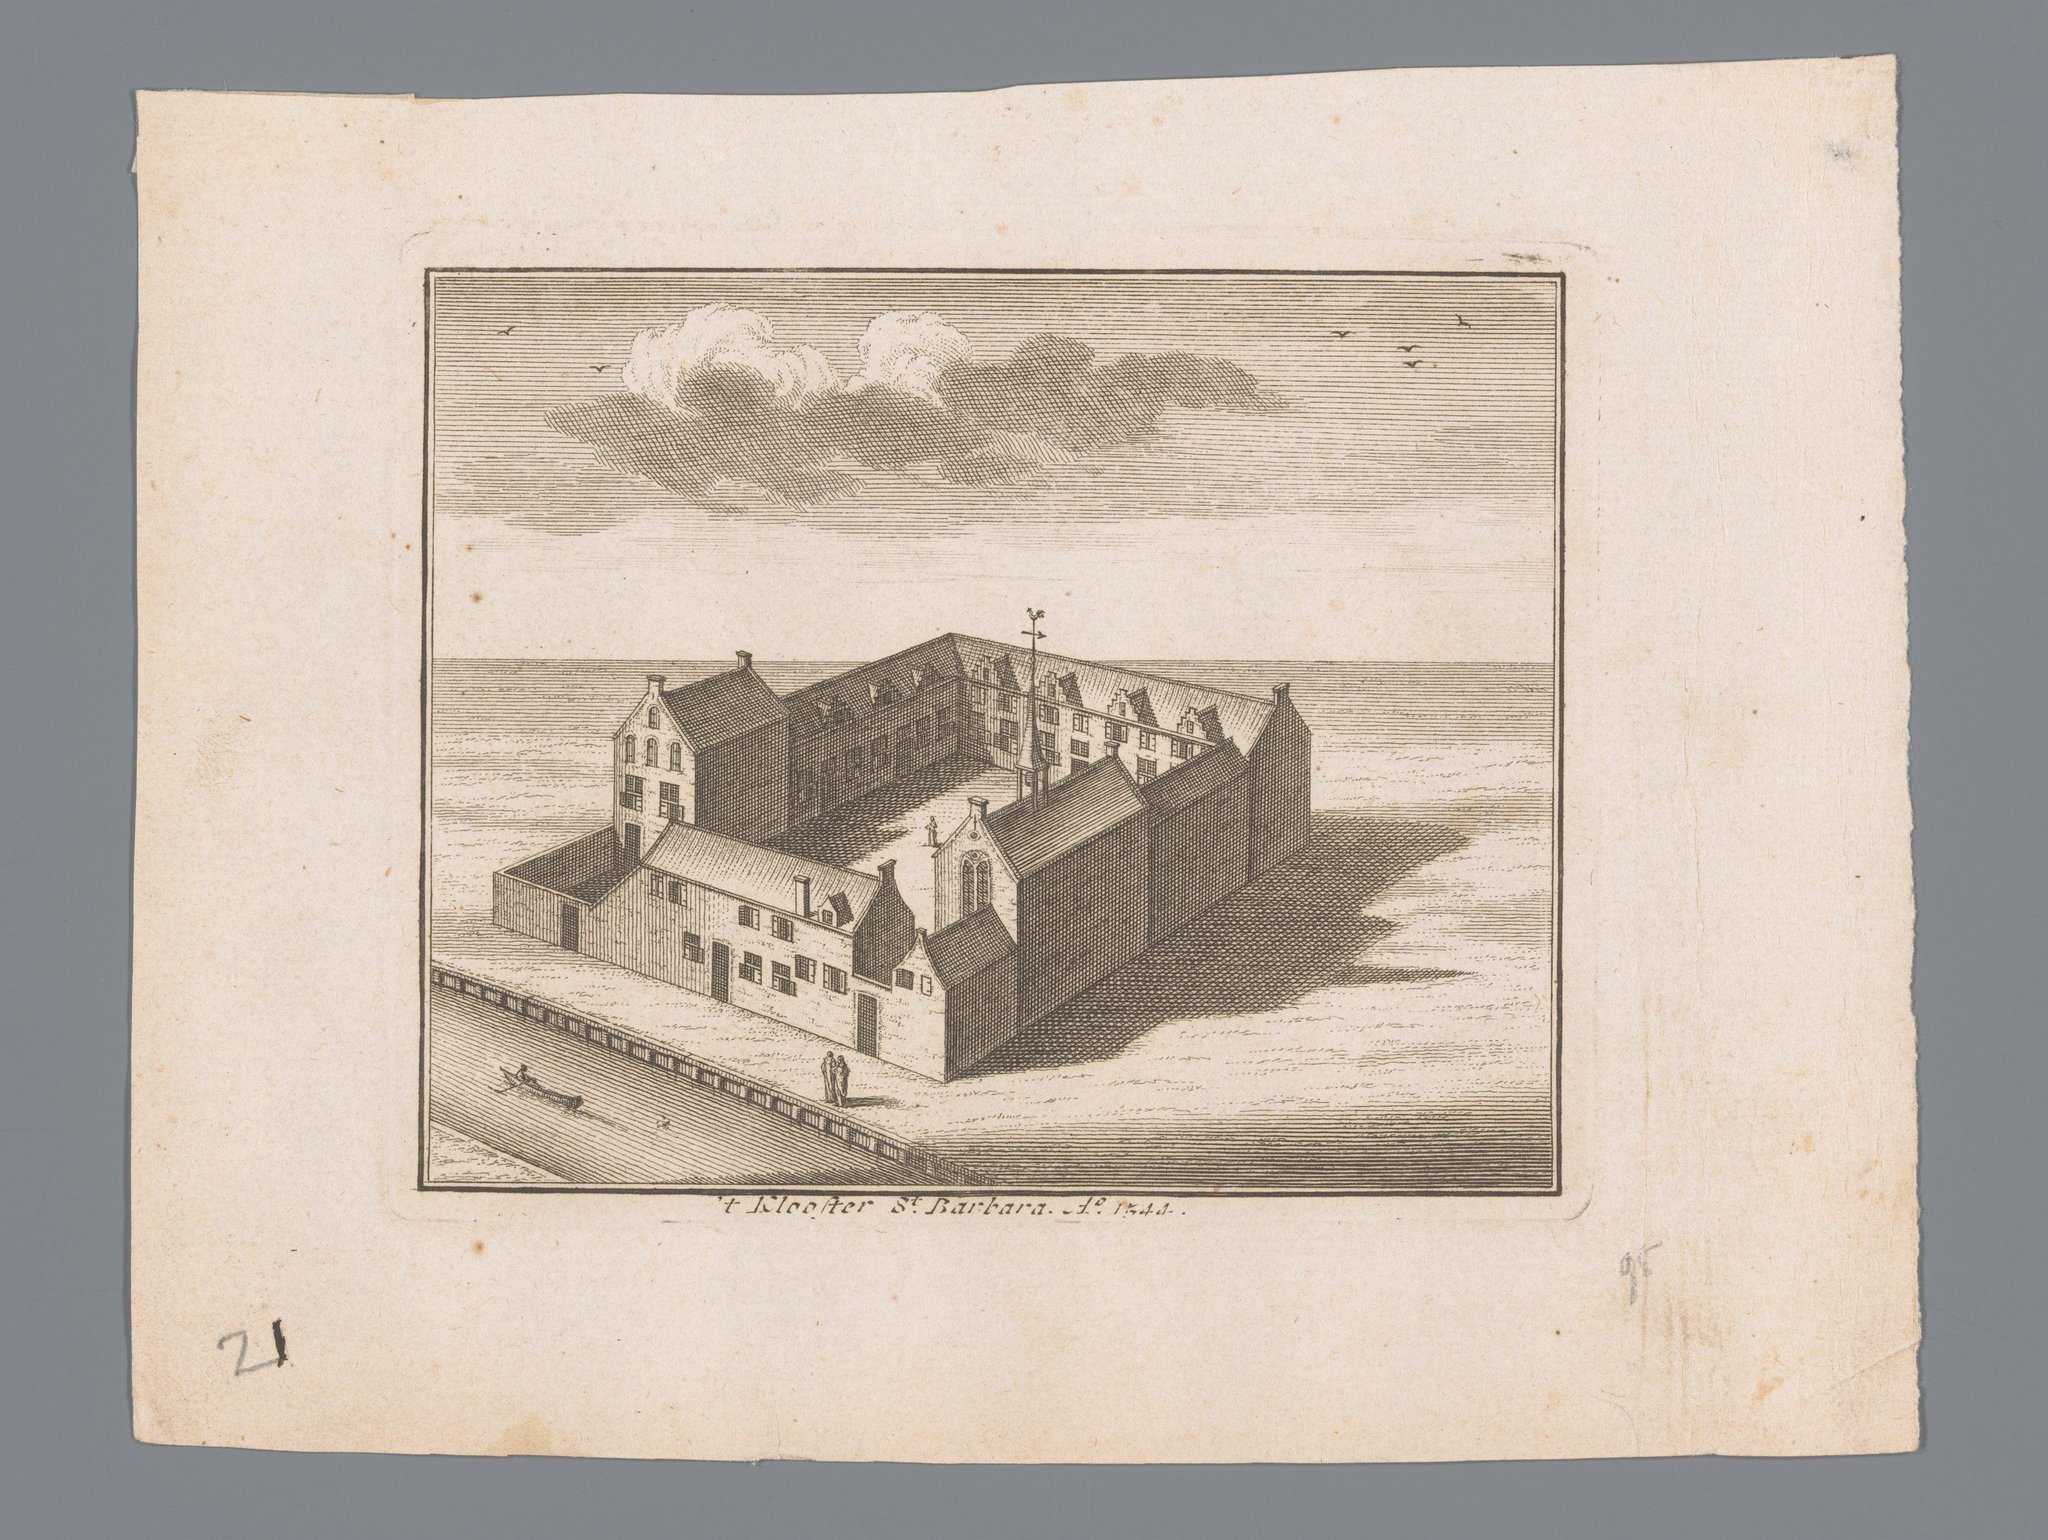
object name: print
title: Gezicht in vogelvlucht op het Sint-Barbaraklooster te Amsterdam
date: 1729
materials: paper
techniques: etching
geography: amsterdam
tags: abbey, monastery, convent ~ roman catholic church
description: Prent verschenen in: Long, Isaak Le. Historische beschryvinge van de Reformatie der stadt Amsterdam. Amsterdam: Johannes van Septeren, 1729.